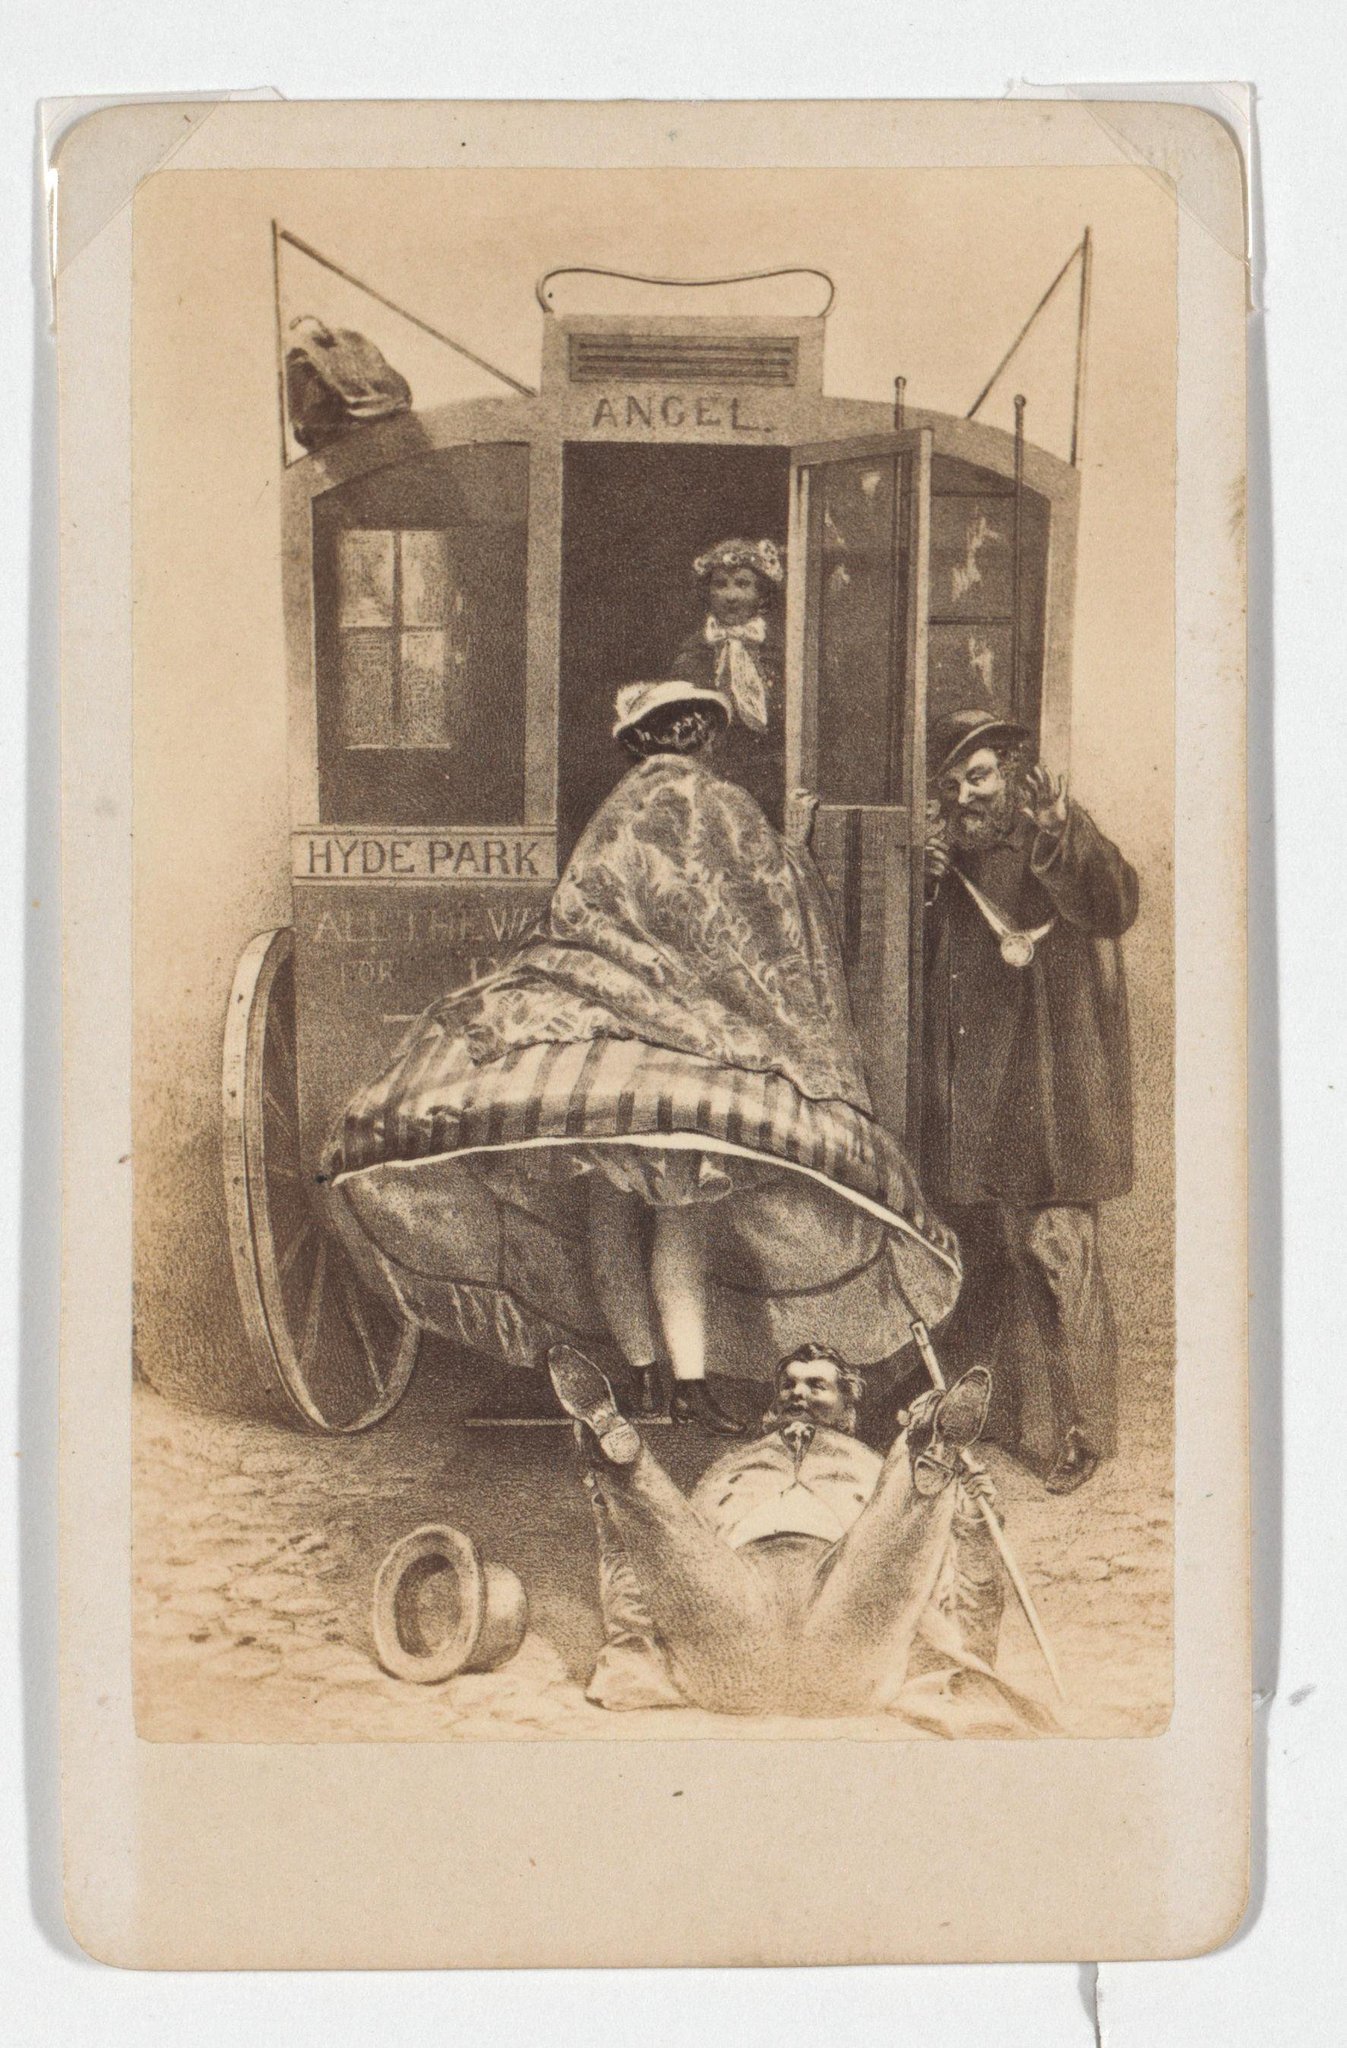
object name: photograph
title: Fotoreproductie van een spotprent op een vrouw met een crinoline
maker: Anonymous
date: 1850-1875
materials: cardboard, paper, photographic support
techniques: albumen print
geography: england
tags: skirt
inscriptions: negative number: ‘1747’